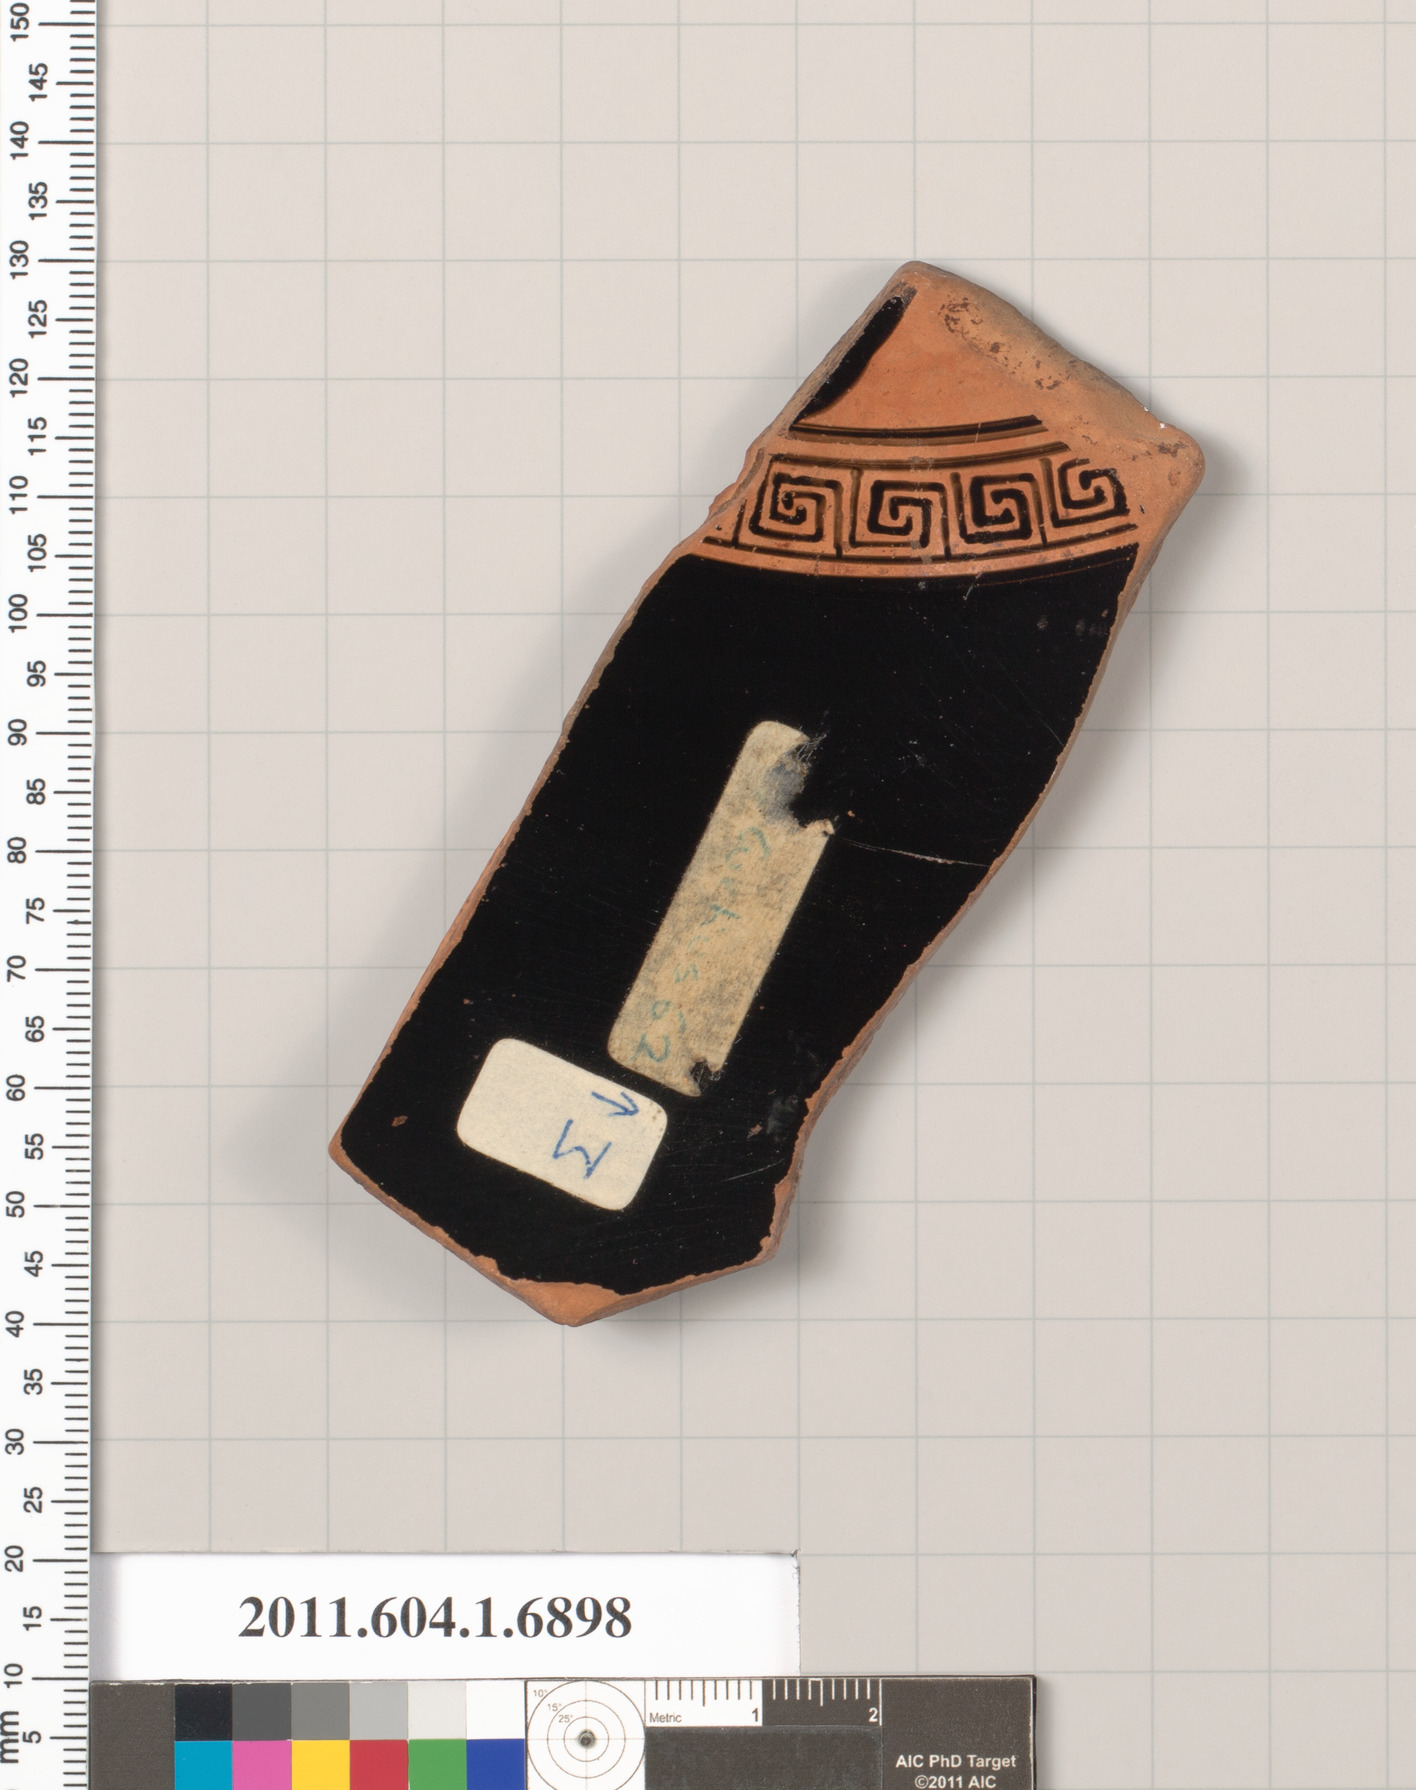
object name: kylix fragment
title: Terracotta fragment of a kylix (drinking cup)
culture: greek, attic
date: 490-470 BCE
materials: terracotta